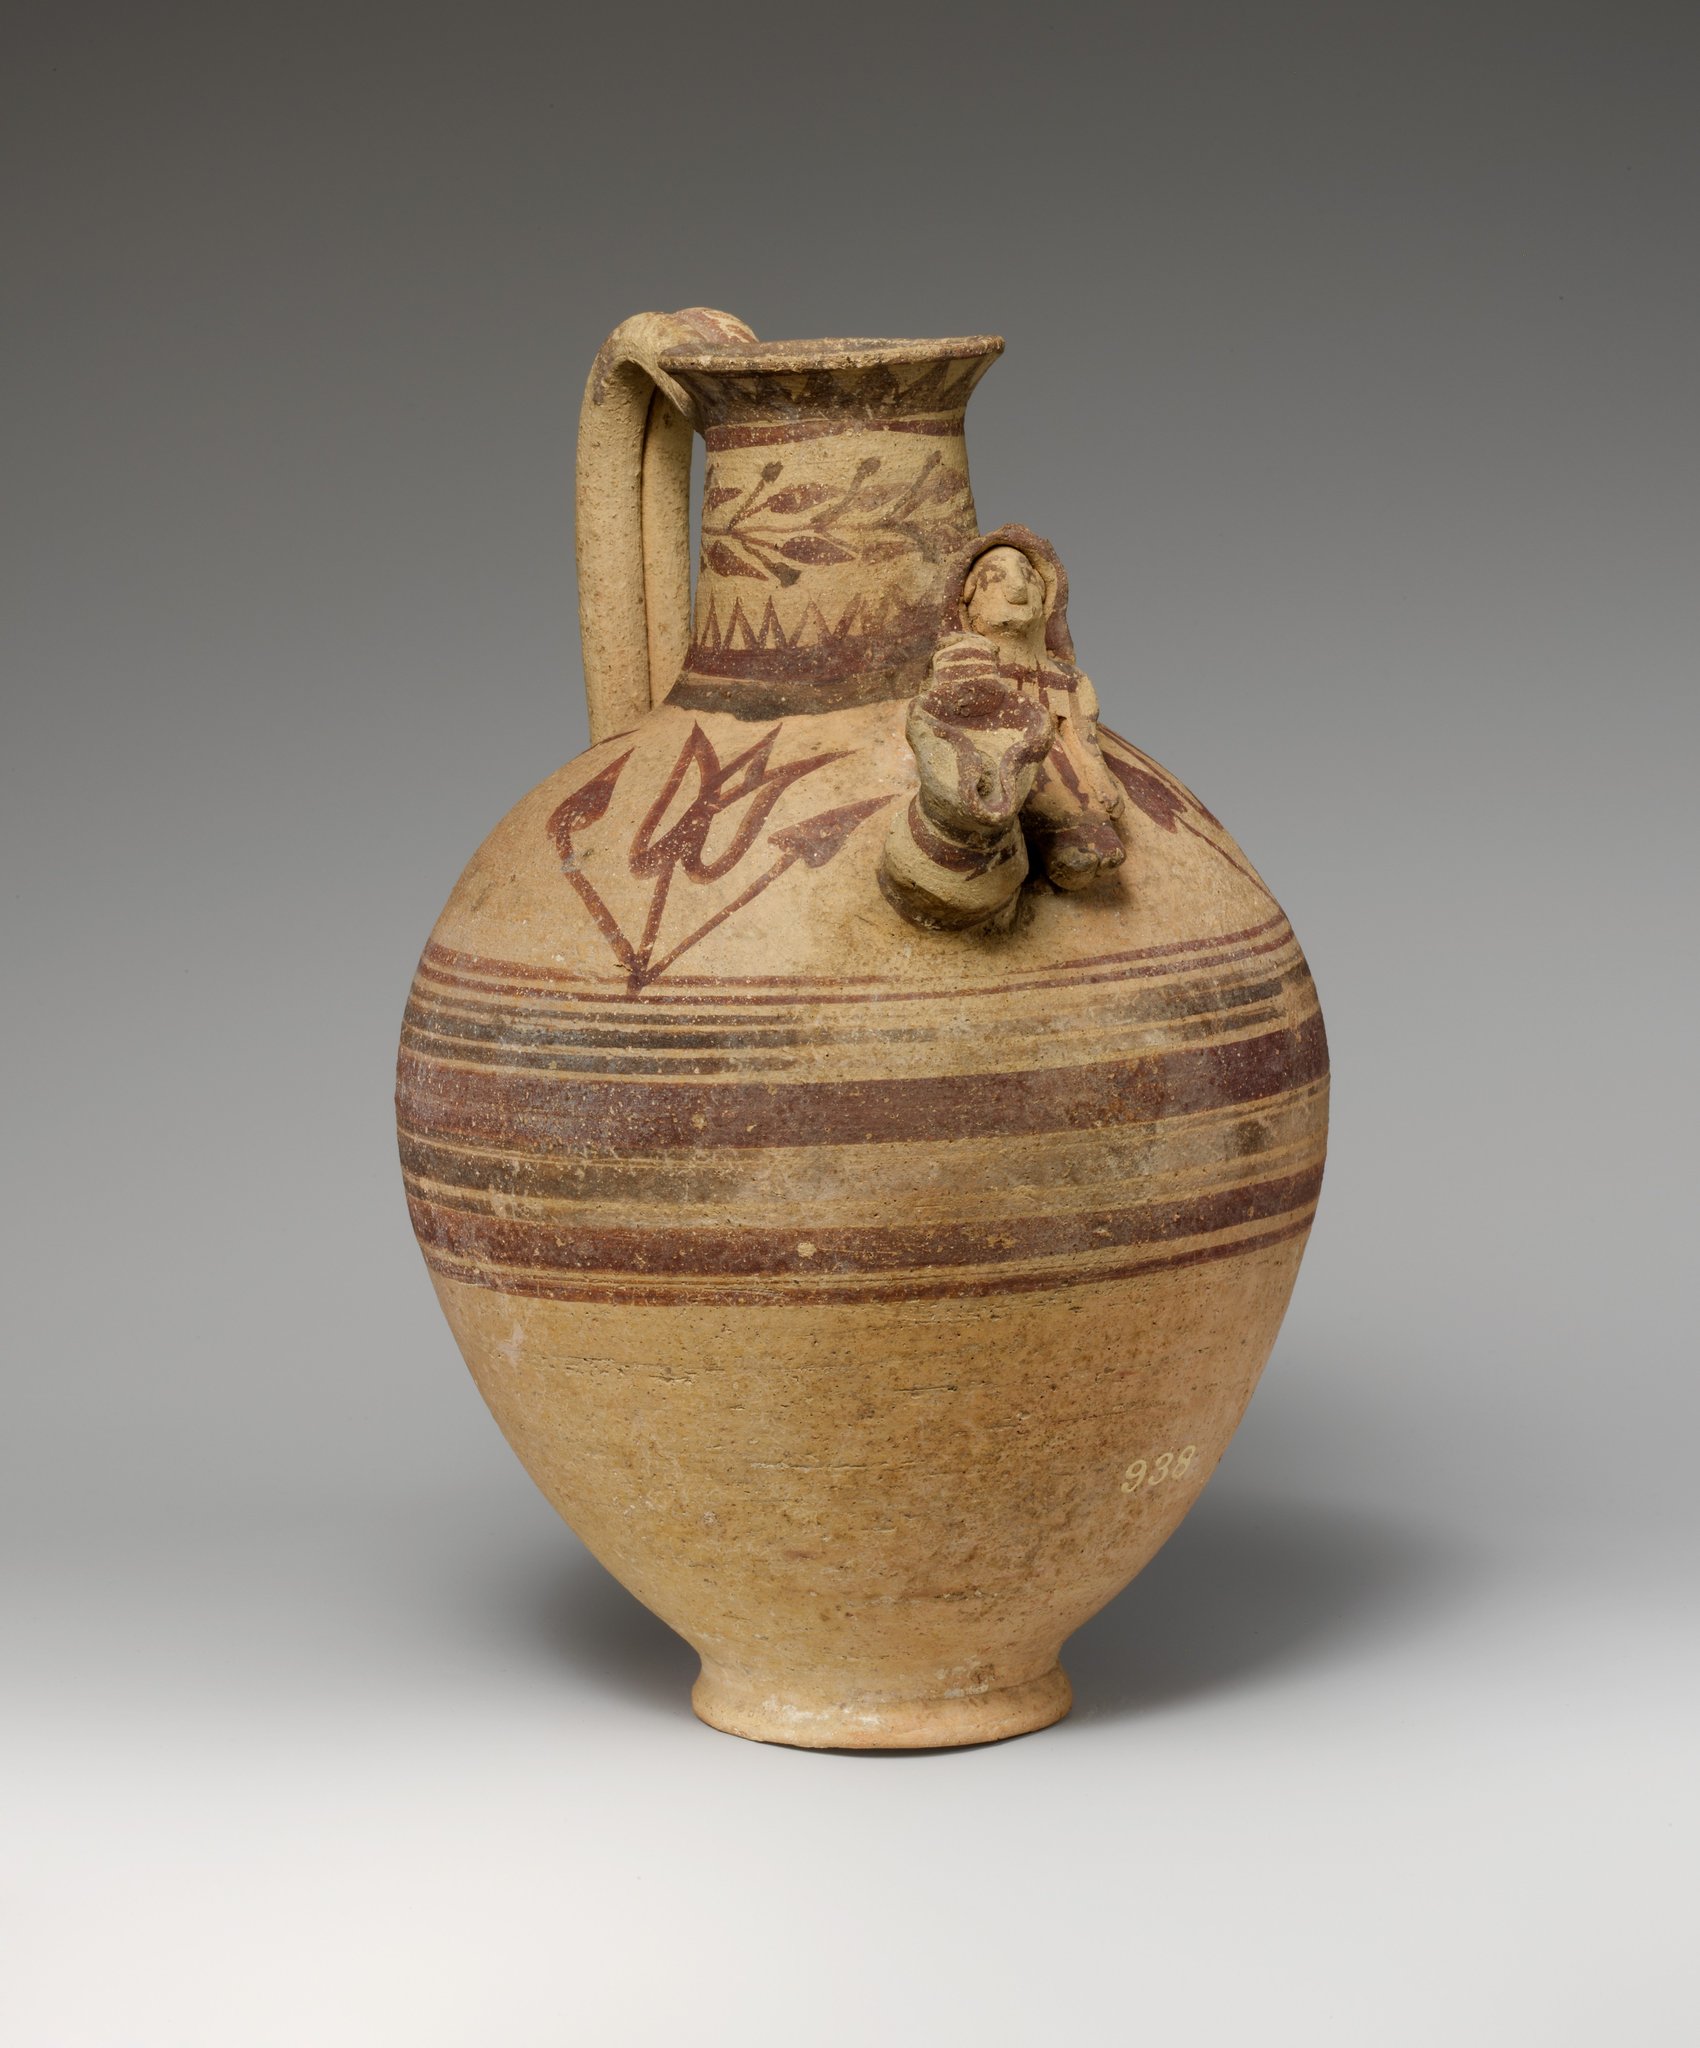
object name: jug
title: Terracotta jug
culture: cypriot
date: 600-480 BCE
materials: terracotta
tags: women